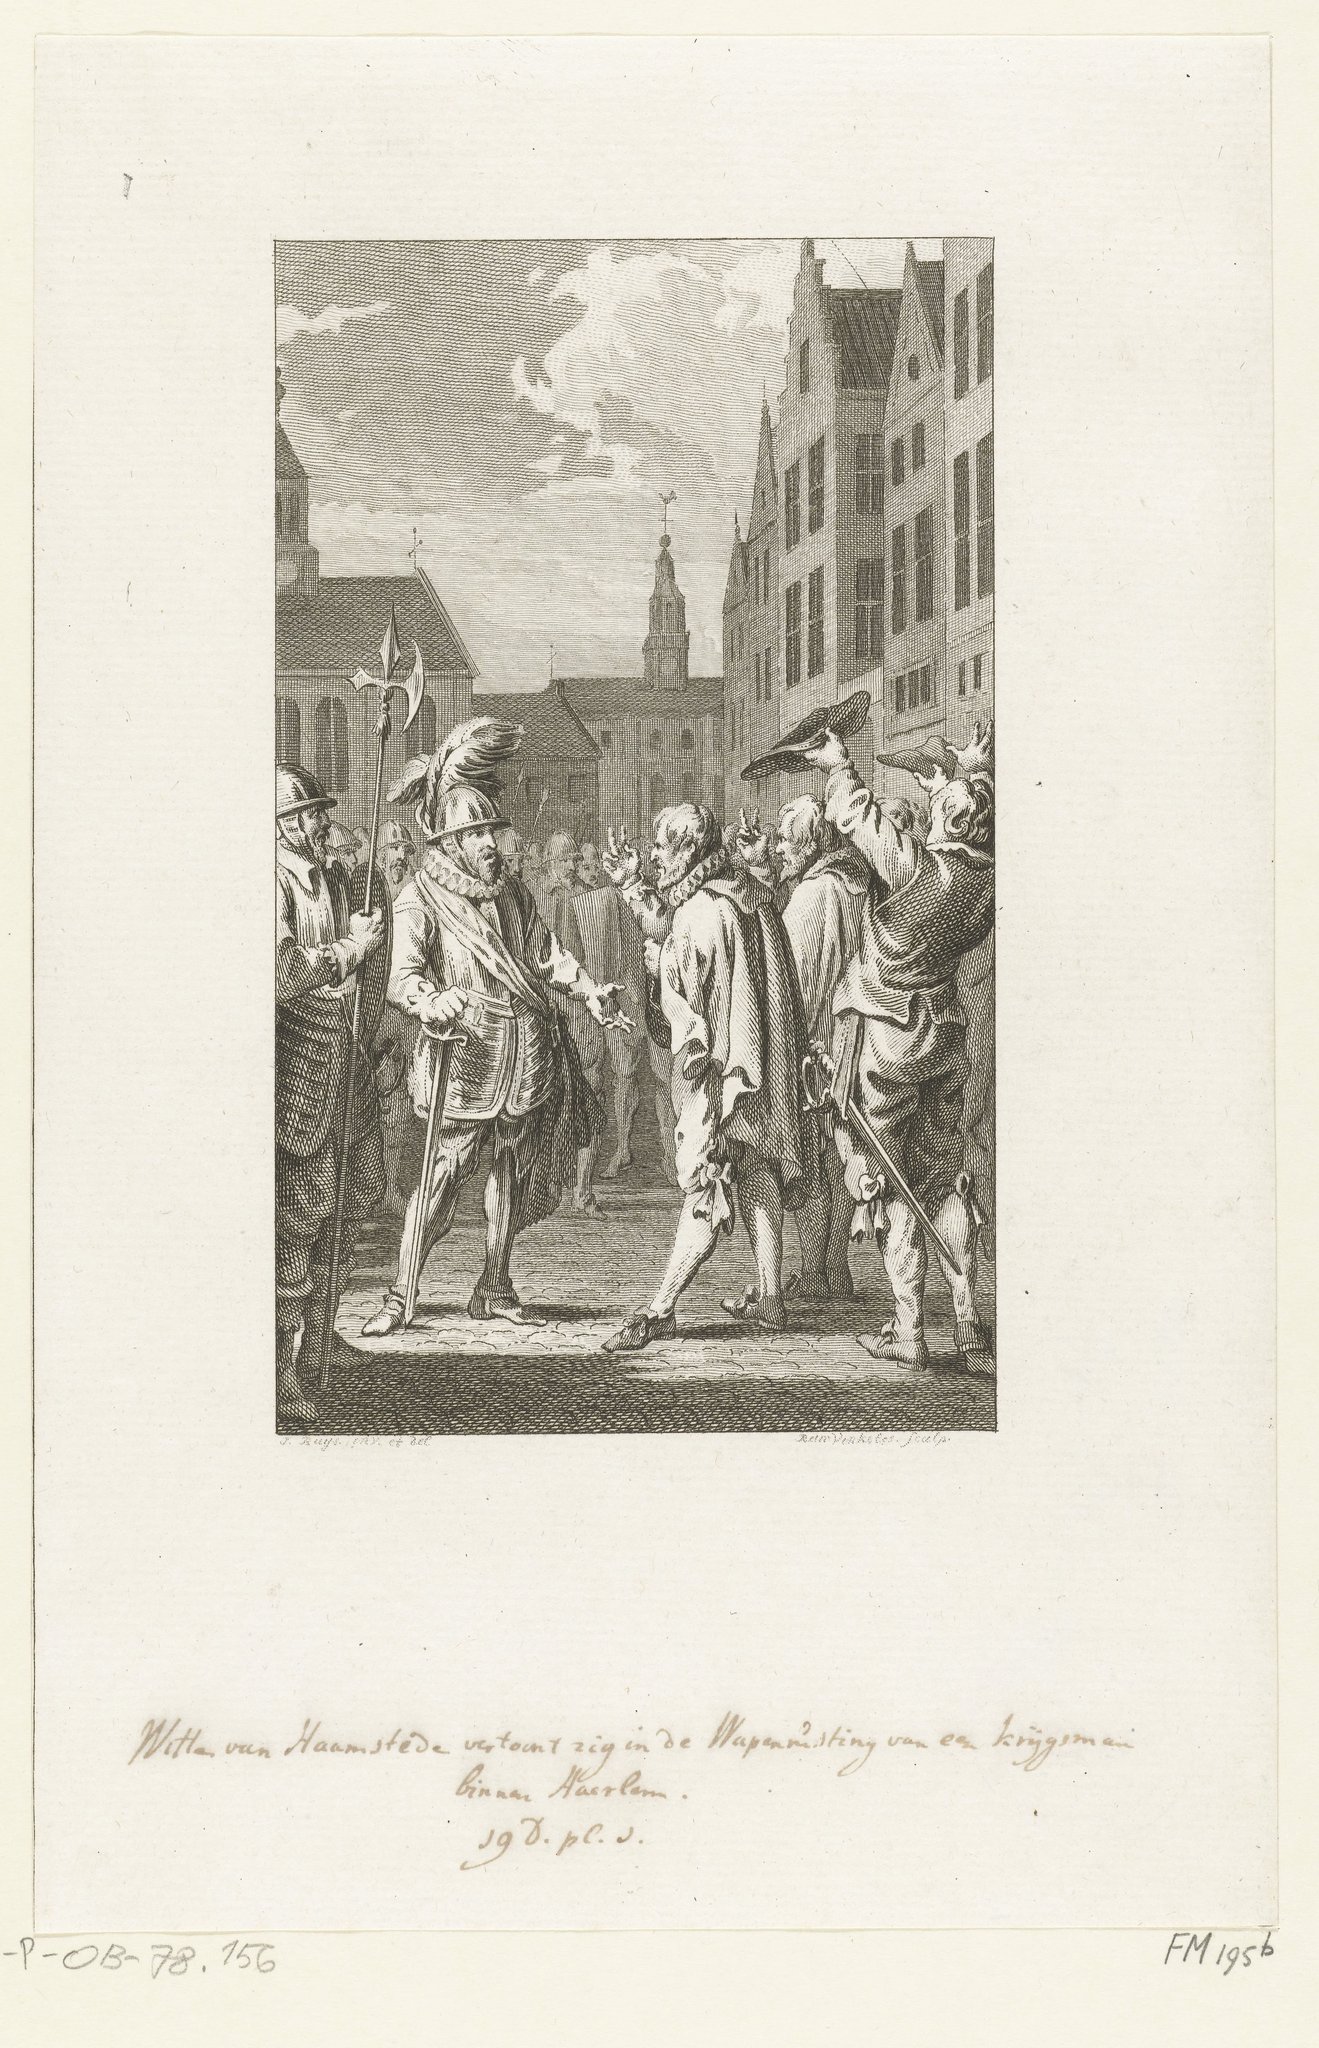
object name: print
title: Witte van Haemstede te Haarlem, 1304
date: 1788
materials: paper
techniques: etching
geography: netherlands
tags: haarlem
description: De ridder Witte van Haemstede in wapenrusting tussen een menigte personen op te Haarlem. Na de overwinning op en de verdrijving van de Vlamingen in 1304.